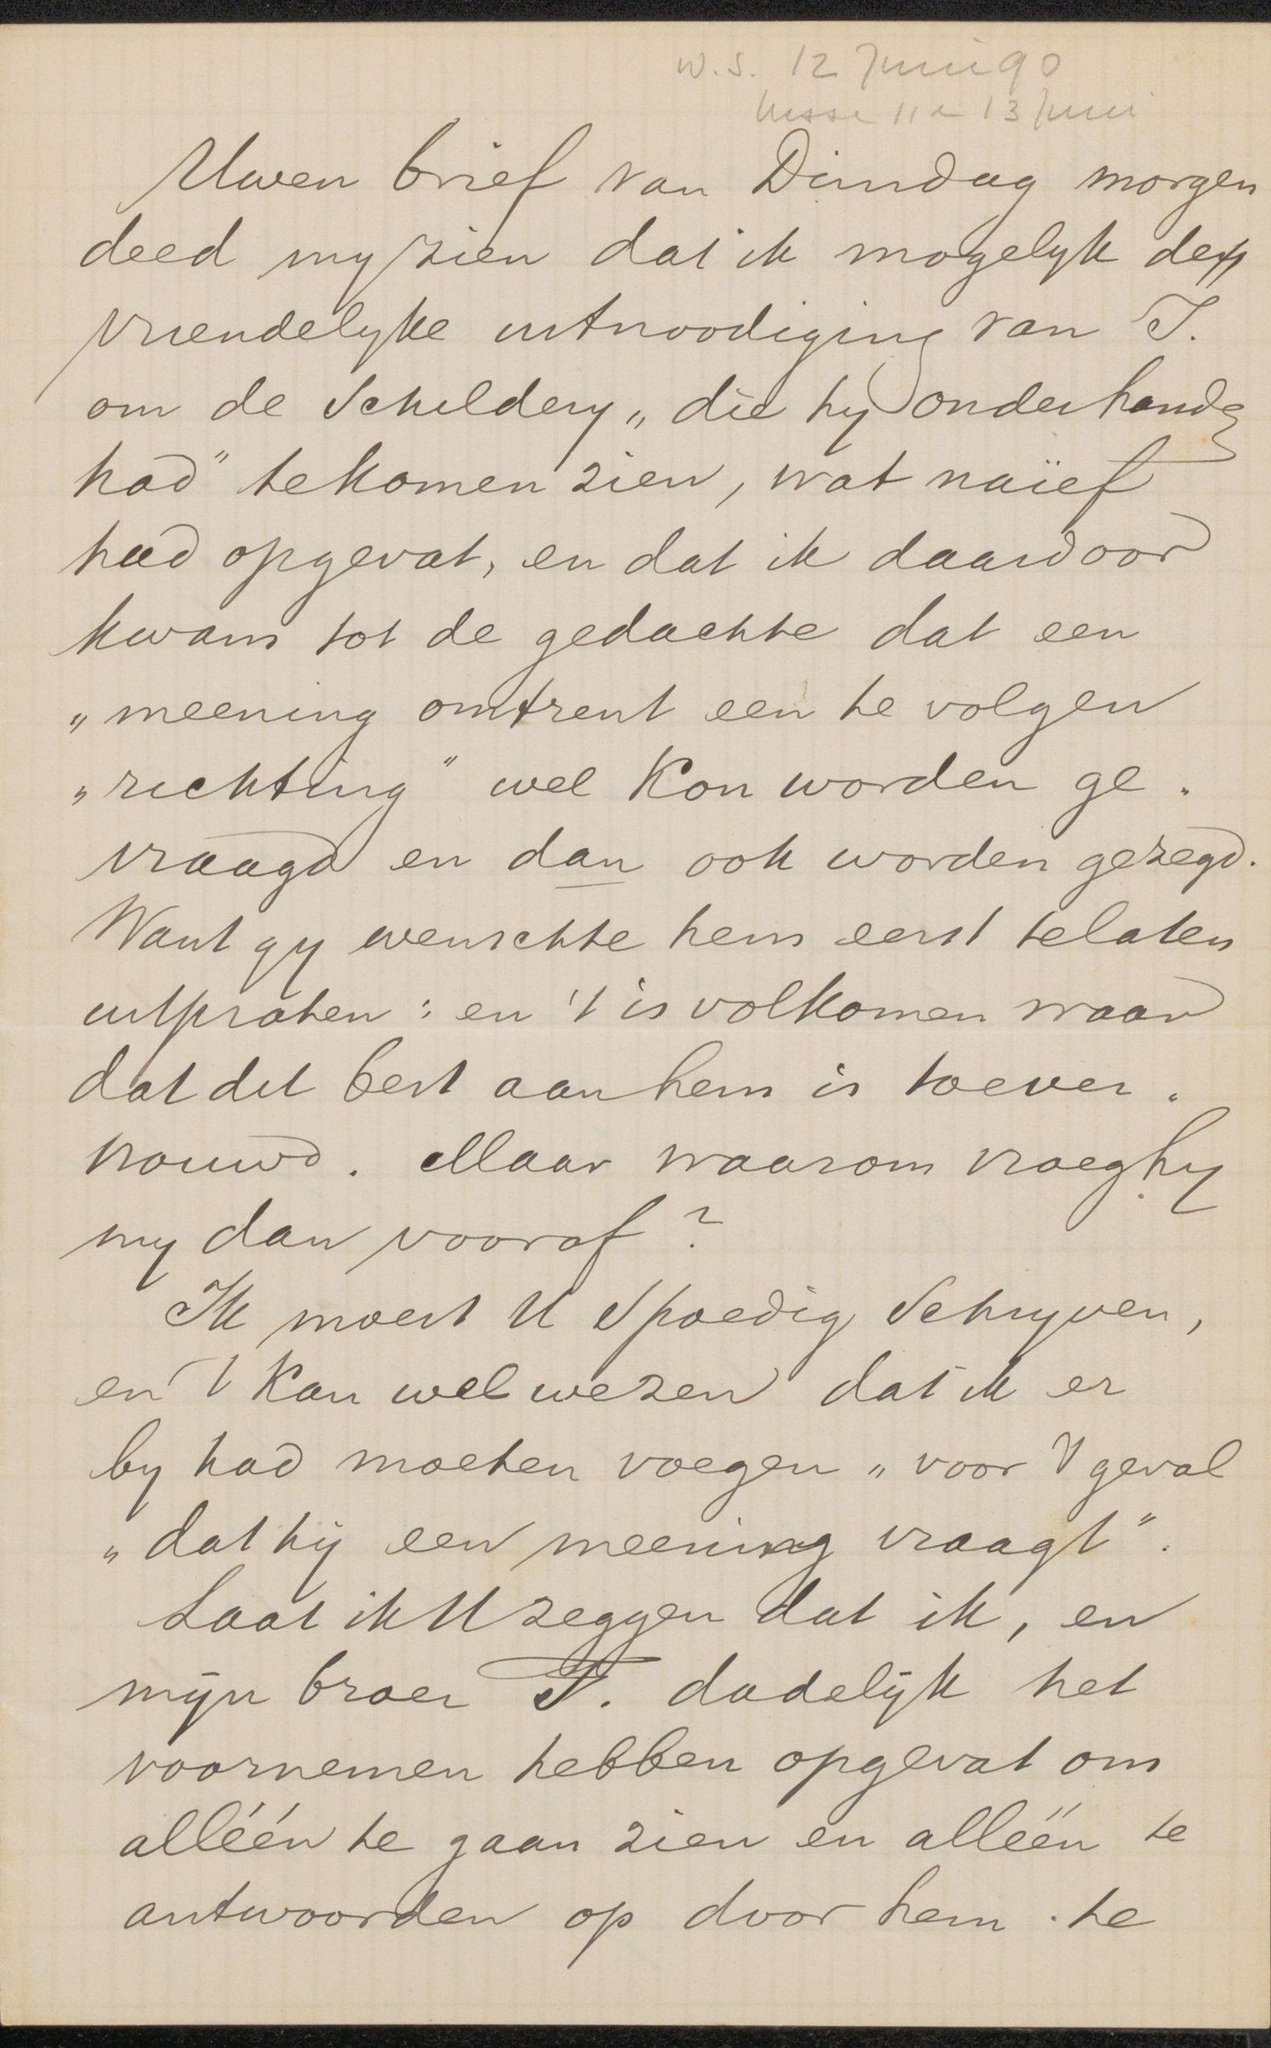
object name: letter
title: Brief aan Jan Veth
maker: martinus cornelis lebret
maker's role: verzamelaar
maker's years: 1833-1894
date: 1874-1894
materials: ink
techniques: pen, writing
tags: jozef israëls, dordrecht, designer, jan veth, leiden, amsterdam, painter, print maker, draughtsman, rembrandt van rijn, historical persons (portraits and scenes from the life), money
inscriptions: collector's mark: ‘RPK’